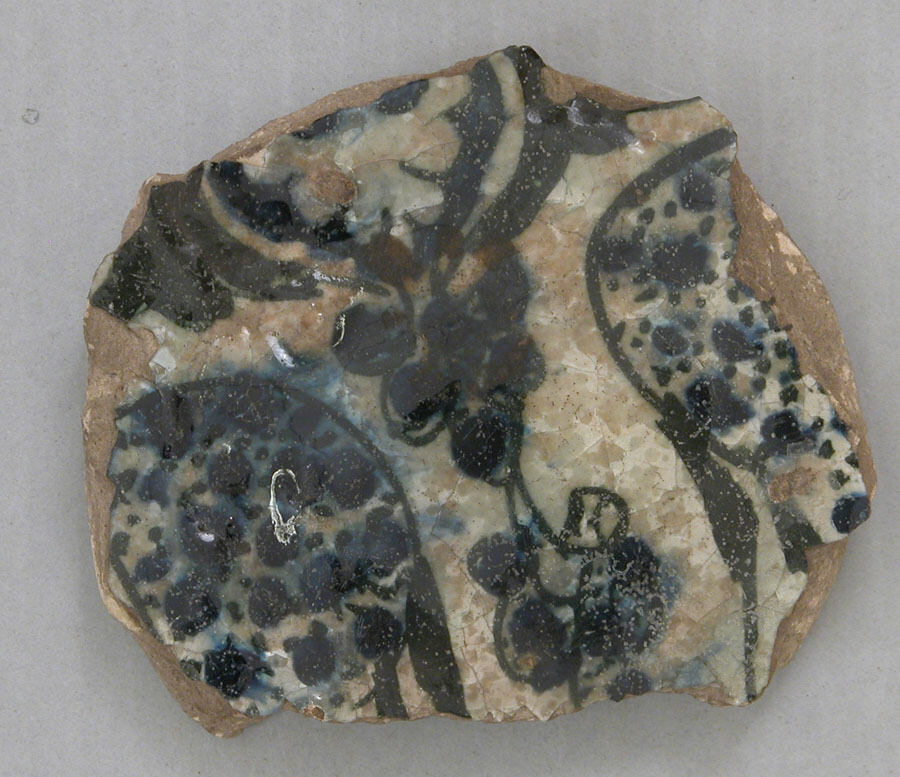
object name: fragment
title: Ceramic Fragment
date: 1301-1500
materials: stonepaste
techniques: painting, underglaze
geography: egypt or syria